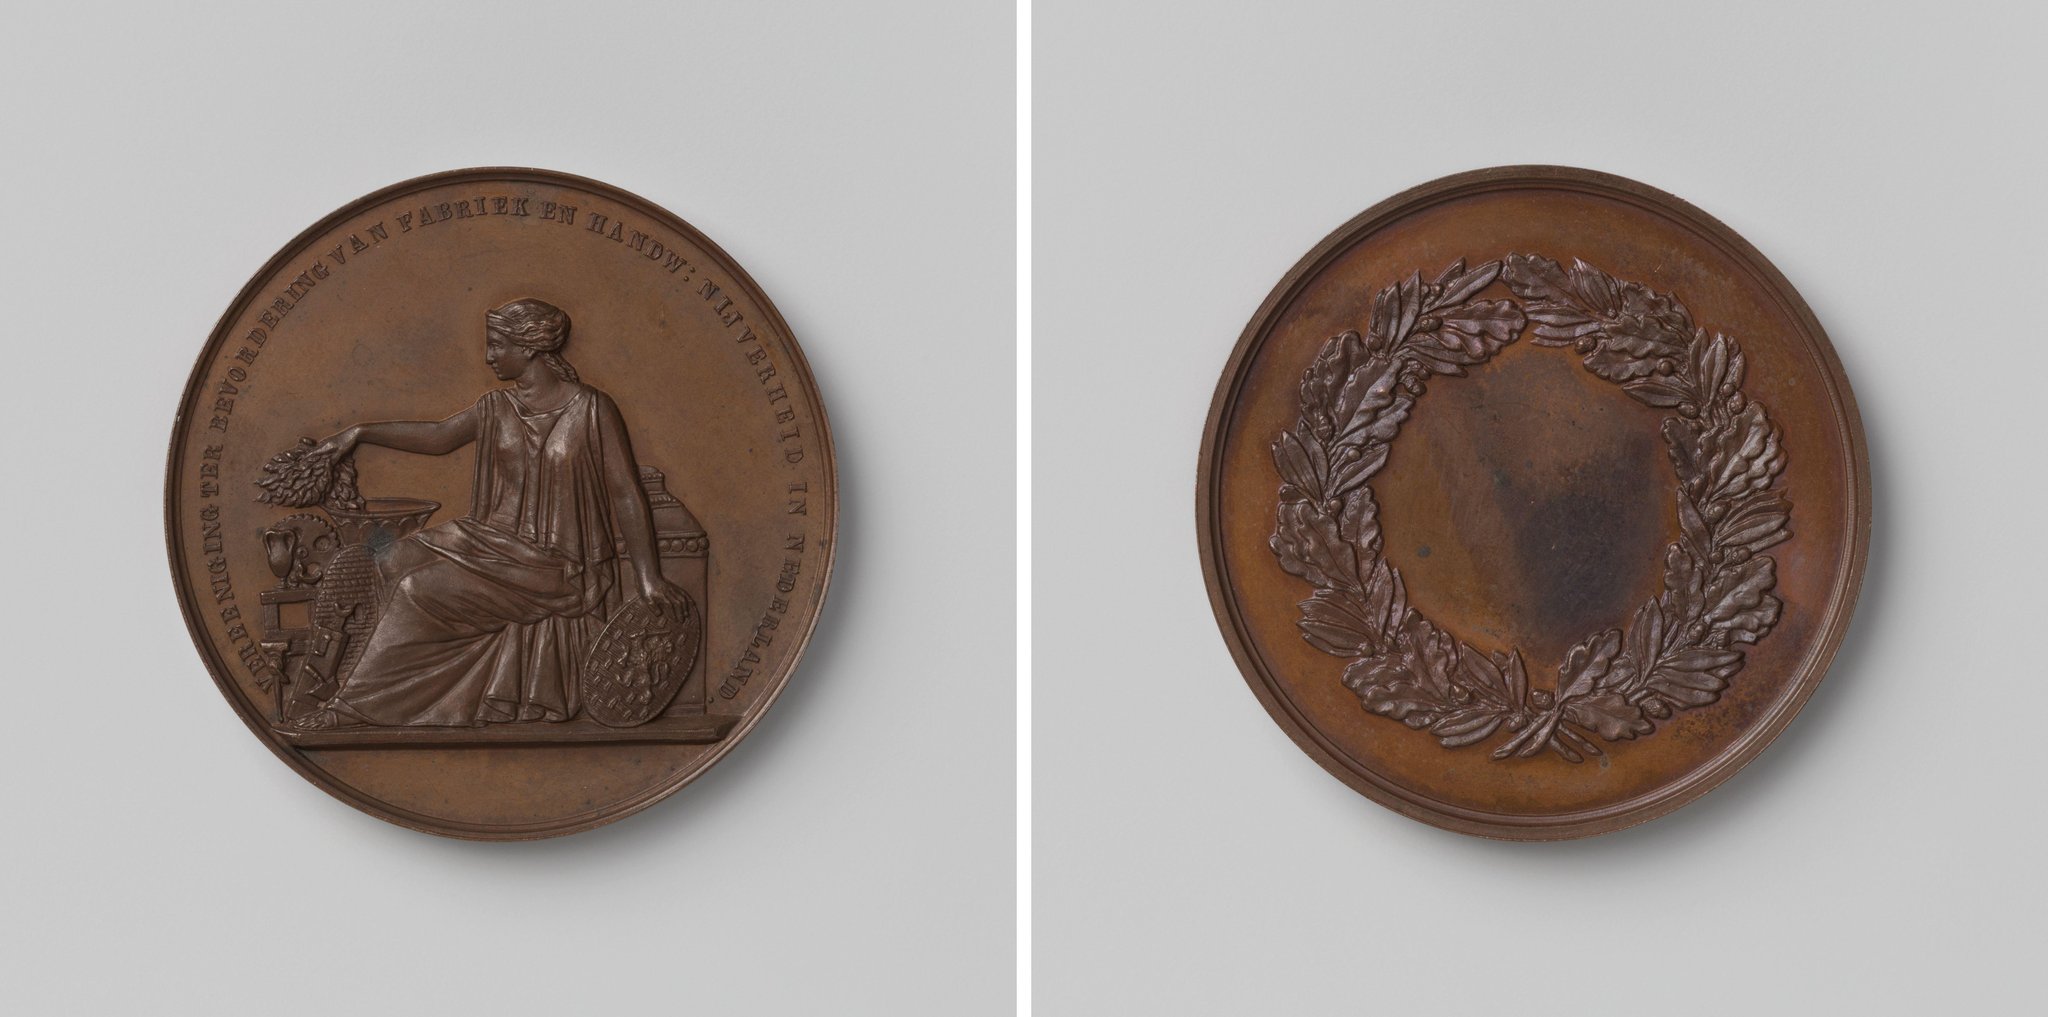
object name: medal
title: Vereeniging ter Bevordering van Fabriek- en Handwerknijverheid in Nederland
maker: karel wiener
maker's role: medailleur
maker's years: 1831-1888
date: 1859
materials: bronze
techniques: striking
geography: the hague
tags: netherlands